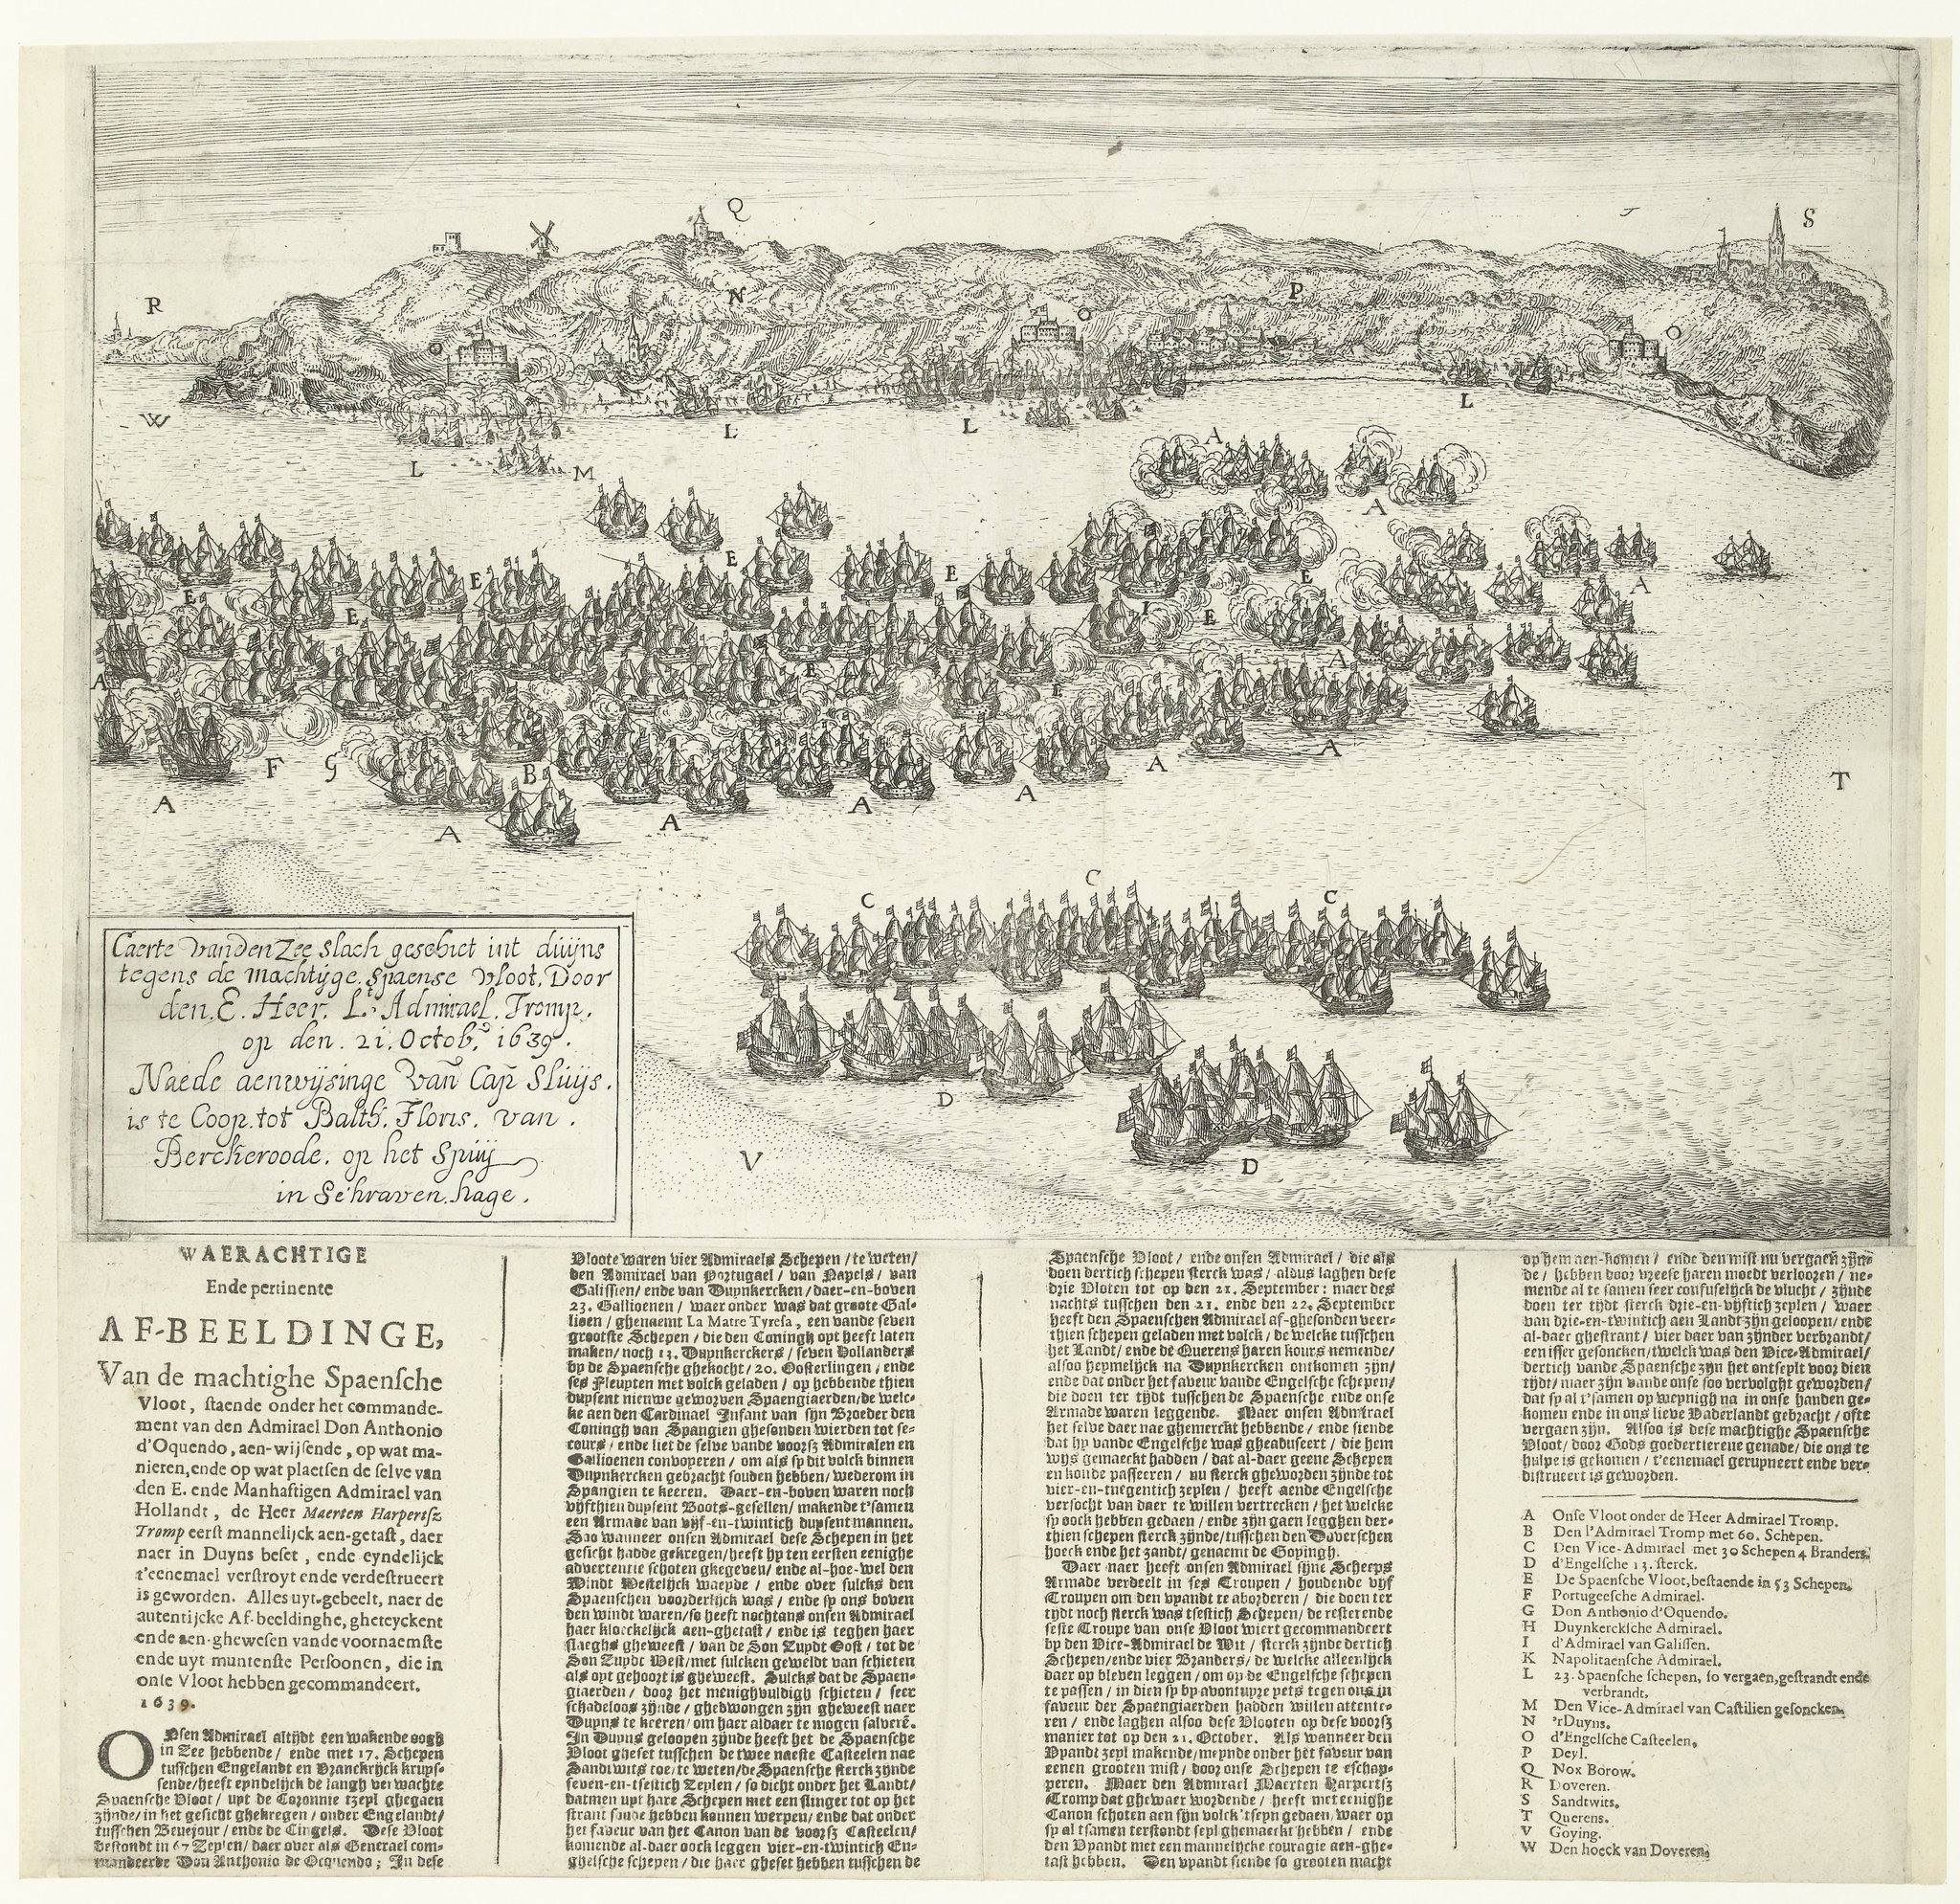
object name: print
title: De zeeslag bij Duins, 1639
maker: balthasar florisz. van berckenrode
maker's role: draughtsman, print maker, publisher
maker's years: 1591-1645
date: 1639-1640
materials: paper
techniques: engraving, etching, letterpress printing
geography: the hague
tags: brielle, maarten harpertszoon tromp, battle (+ naval force), battle of the downs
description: De zeeslag bij Duins tussen de Spaanse vloot onder bevel van Antonio de Oquendo en de Staatse vloot onder Maarten Harpertsz. Tromp, 21 oktober 1639. Overzicht van de zeeslag voor de Engelse kust tussen Sandwich en Dover. Op de prent is een tekstblad vastgeplakt met een beschrijving in 4 kolommen van de gebeurtenissen en de legenda A-W in het Nederlands.